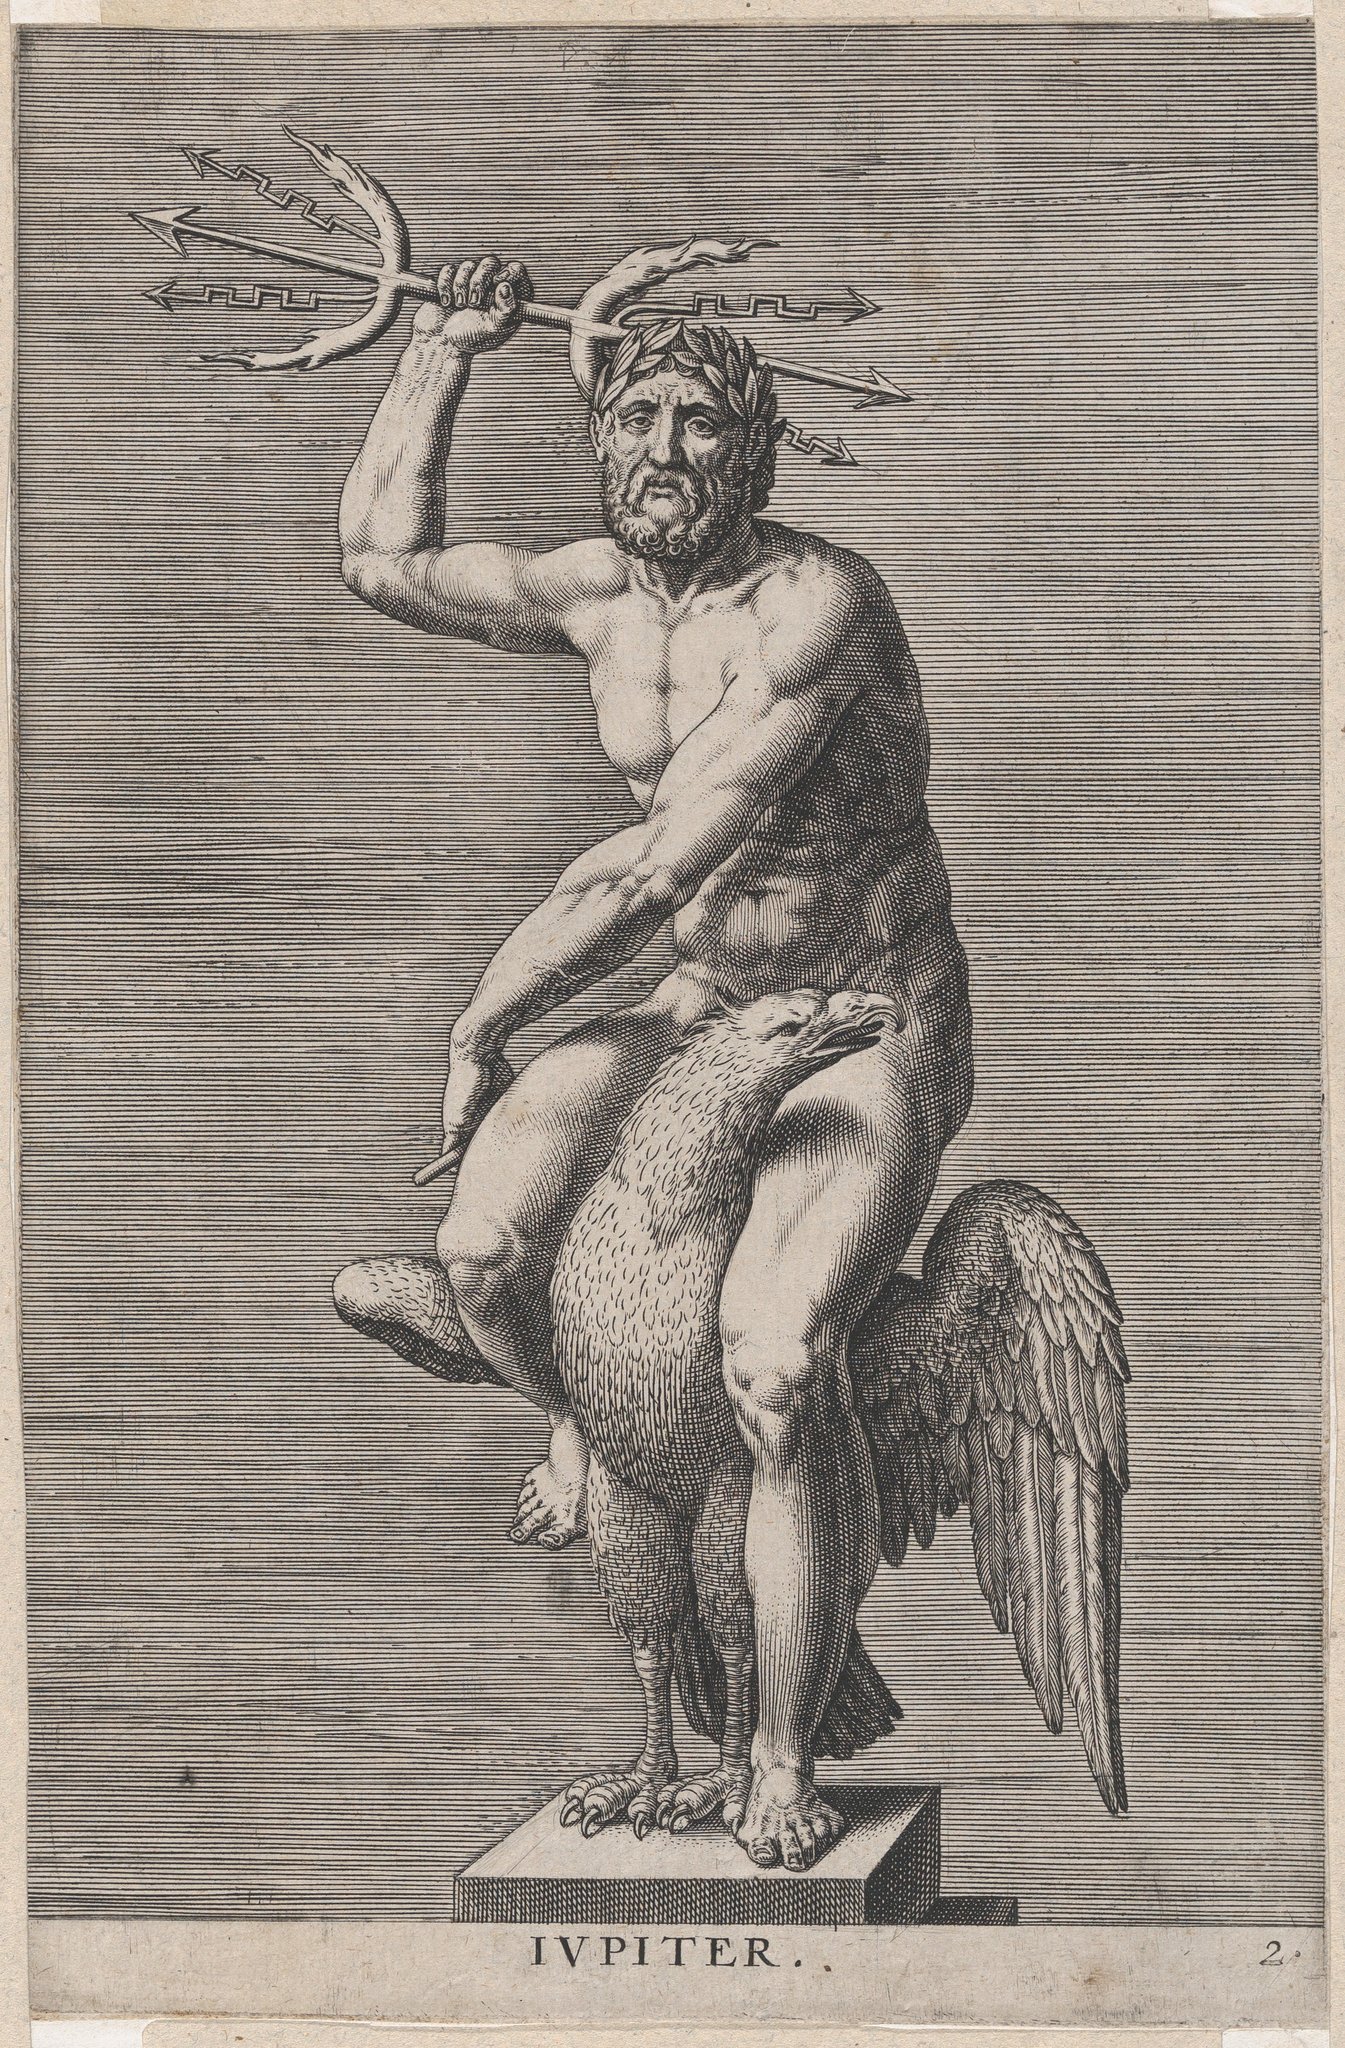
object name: print, fete, ornament architecture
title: Jupiter; statue of the nude god seated on an eagle, holding a double trident, plate 2 from "Statues of Roman Gods"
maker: philips galle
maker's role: artist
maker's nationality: netherlandish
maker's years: 1537-1612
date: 1586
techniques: engraving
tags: eagles,weapons,jupiter